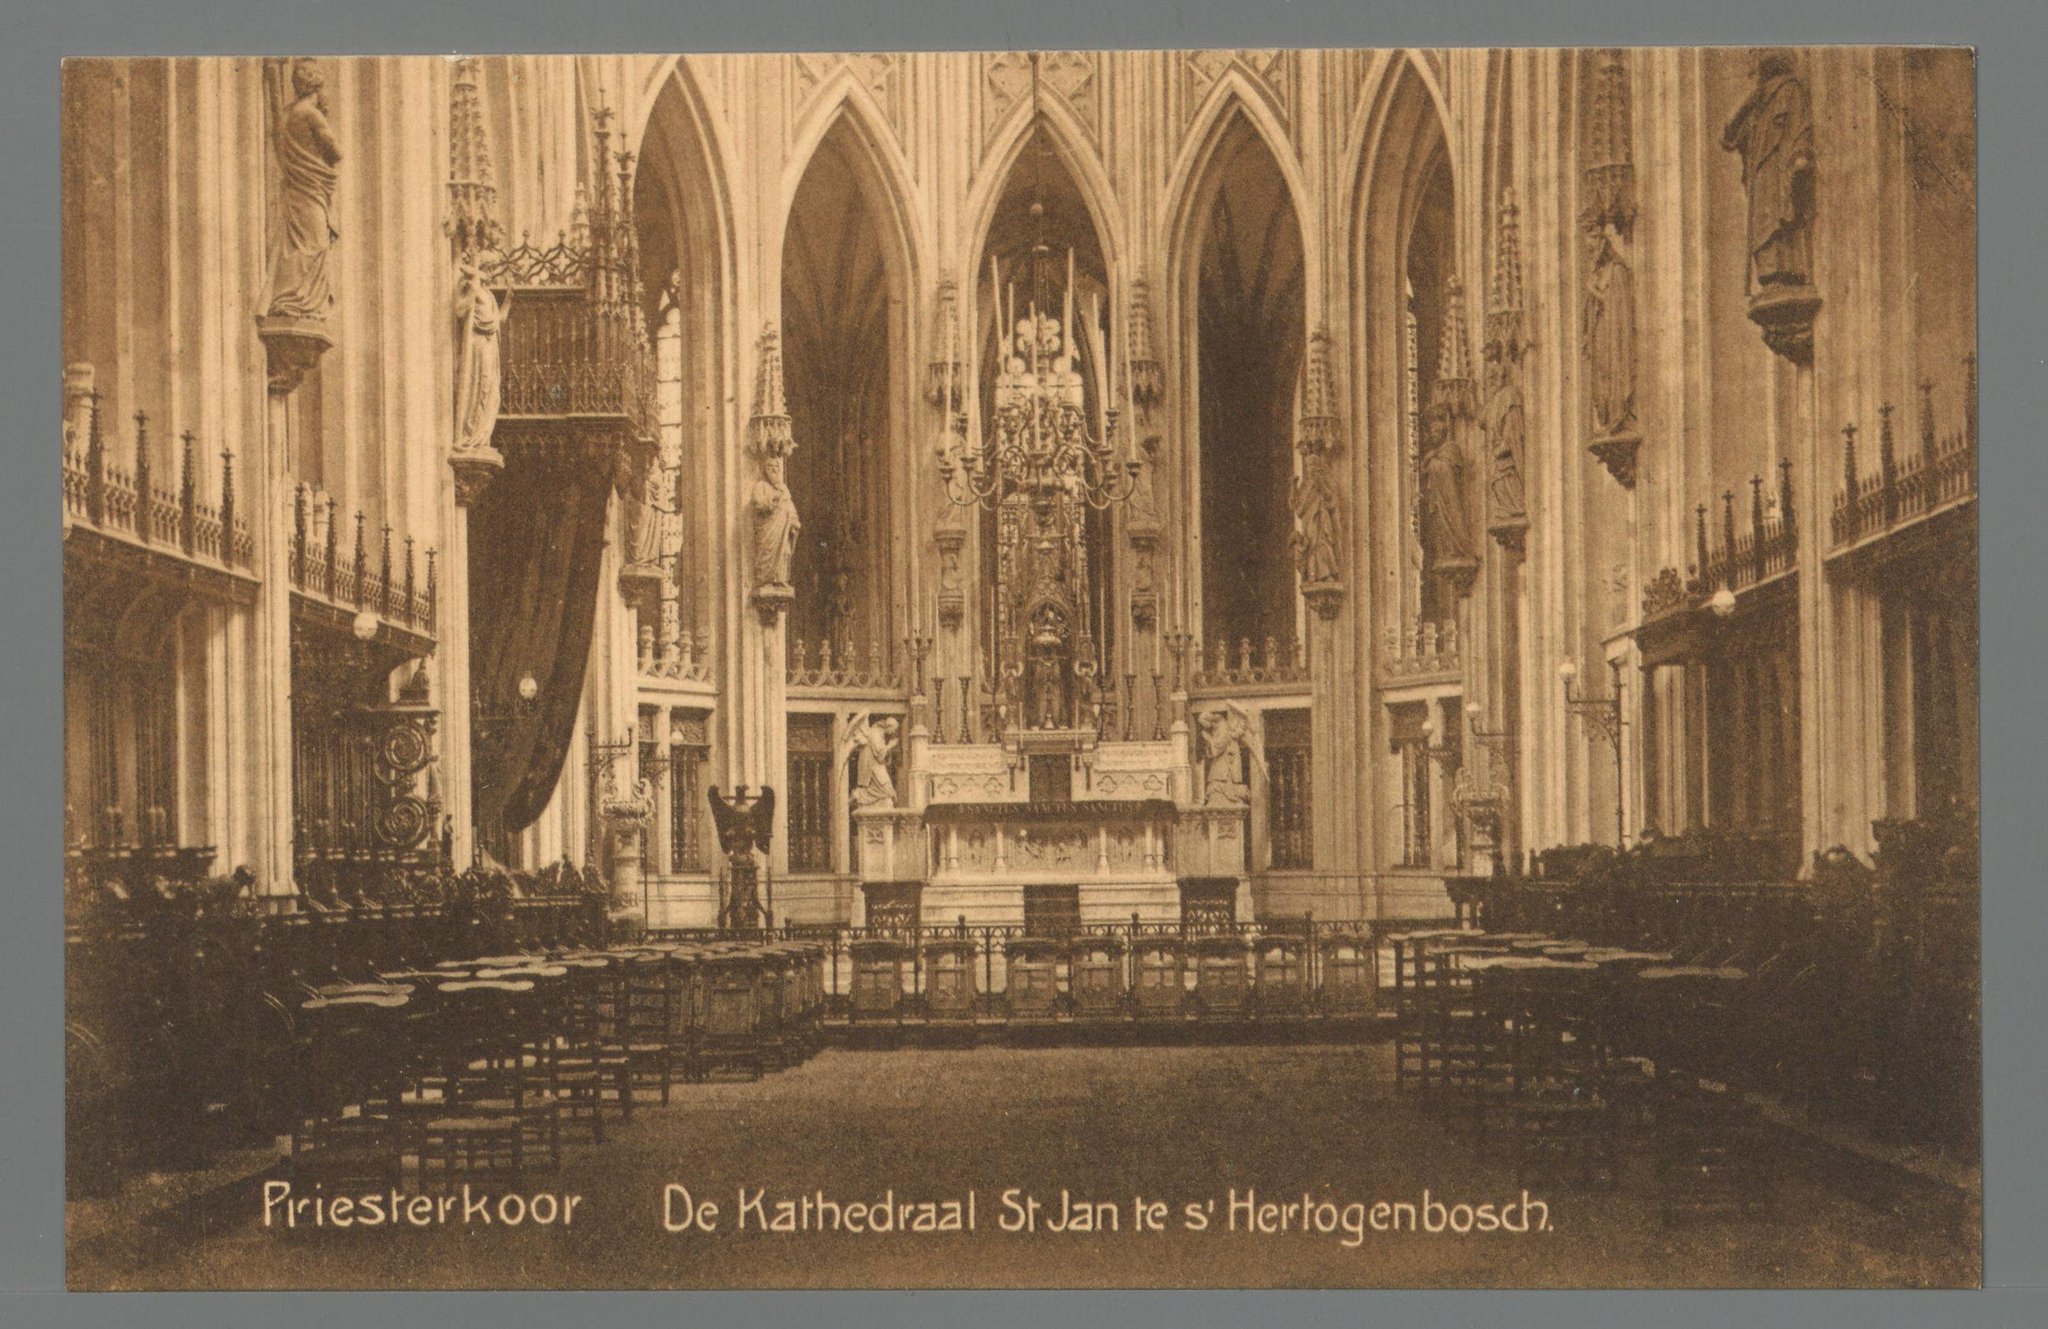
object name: ansichtkaart, prentbriefkaart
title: Priesterkoor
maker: Anonymous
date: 1905-1930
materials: cardboard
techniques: photograph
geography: den bosch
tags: parts of church interior: choir, altar with altar-piece